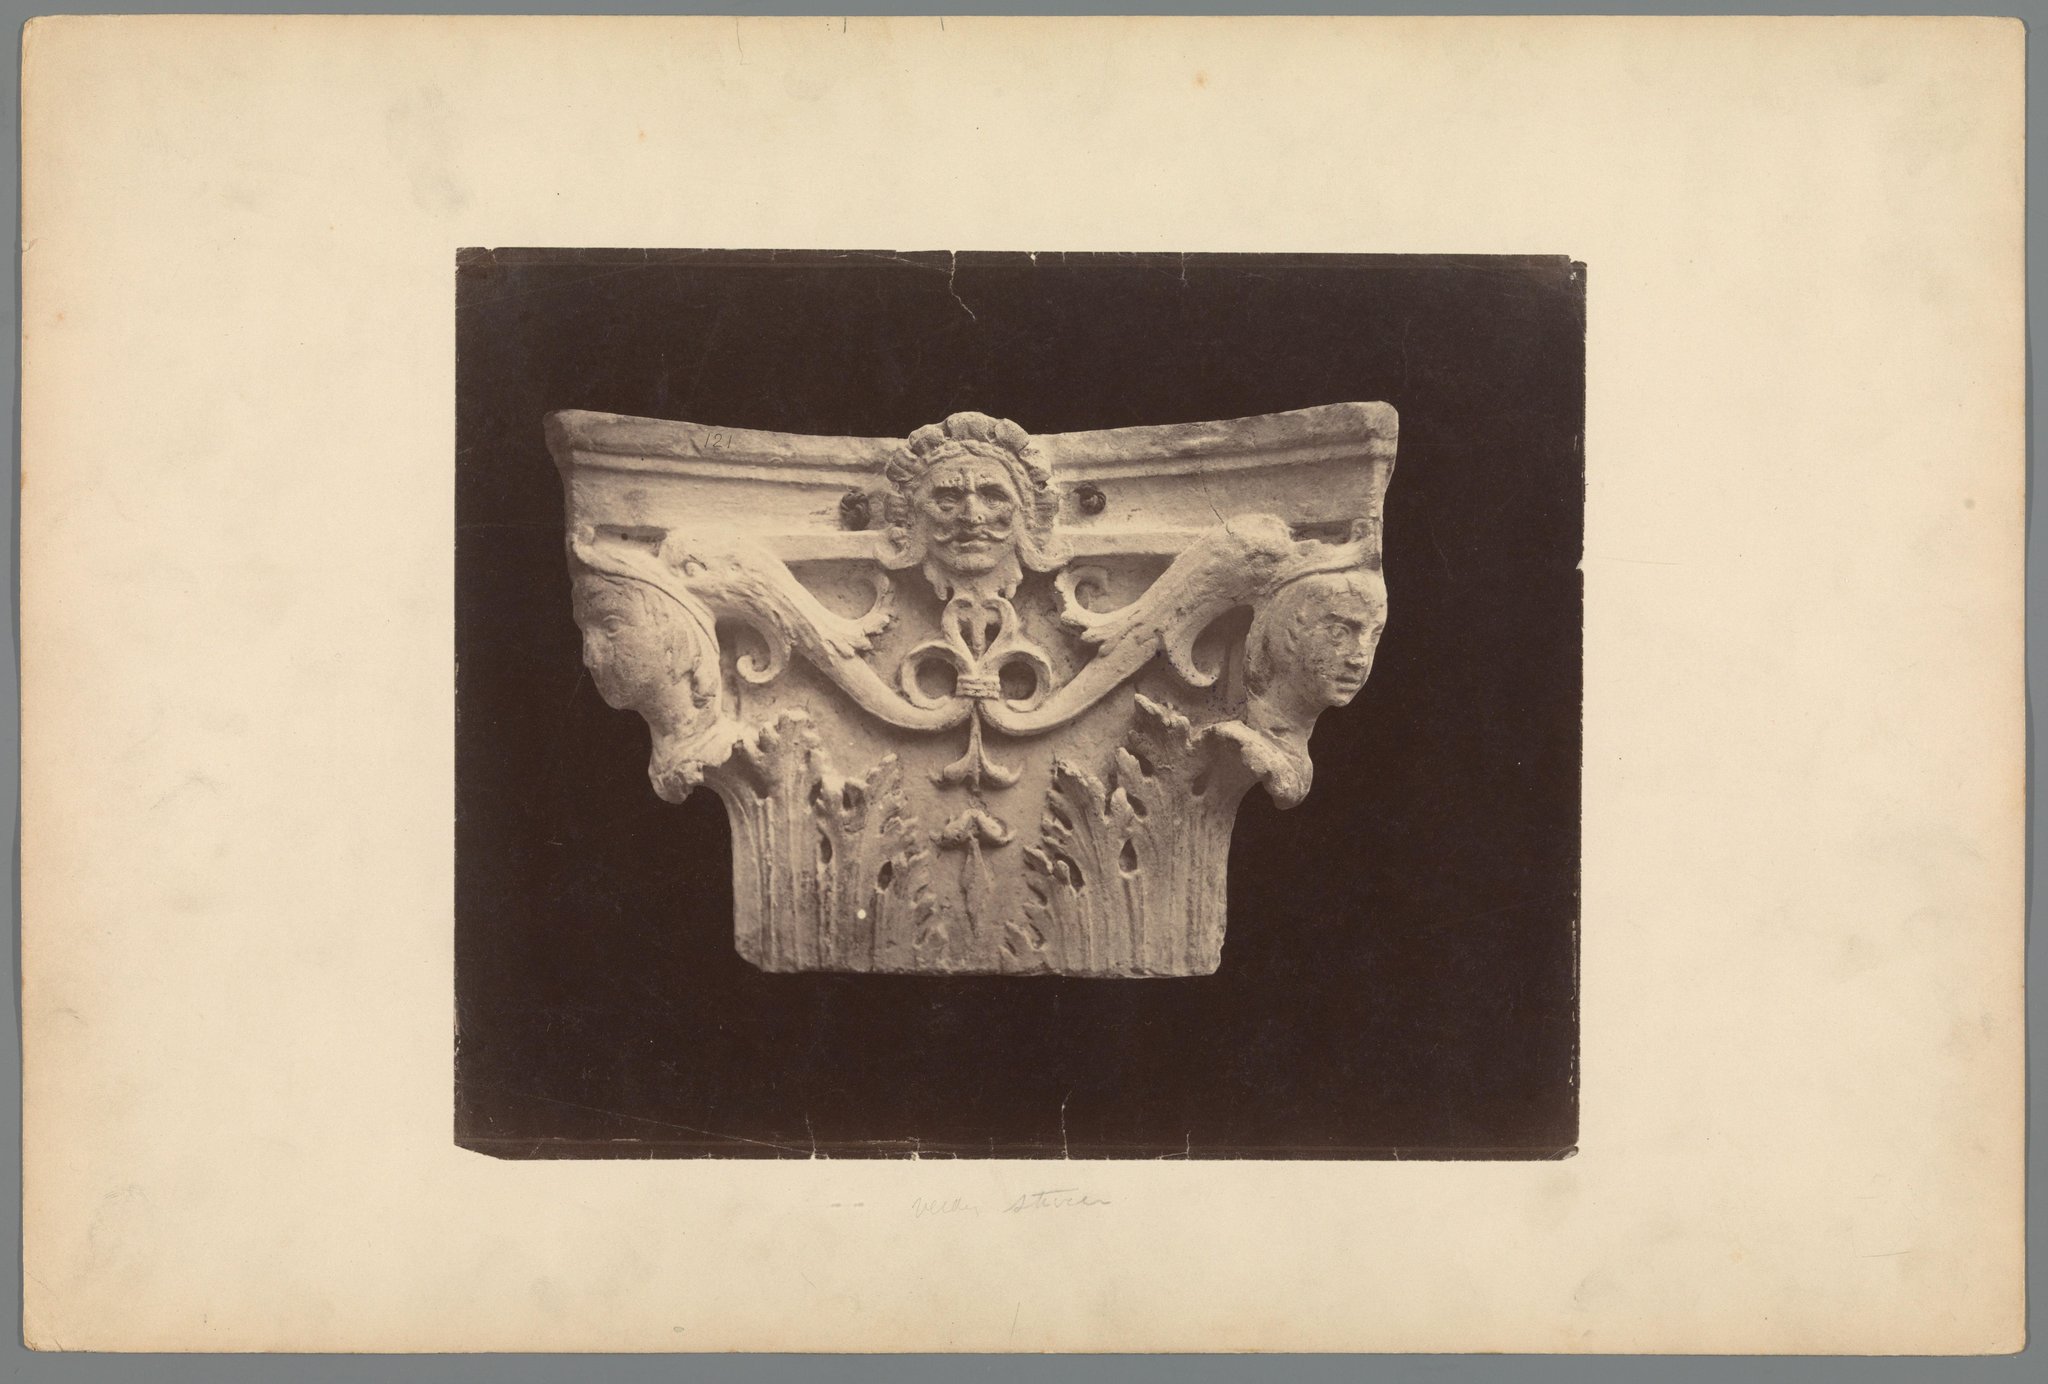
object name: photograph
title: Kapiteel gedecoreerd met mensenhoofden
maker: Anonymous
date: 1875-1900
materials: cardboard, photographic support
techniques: albumen print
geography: europe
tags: head (human), capital (~ column, pillar), europe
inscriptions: collector's mark: Lugt 3937, number: ‘121’